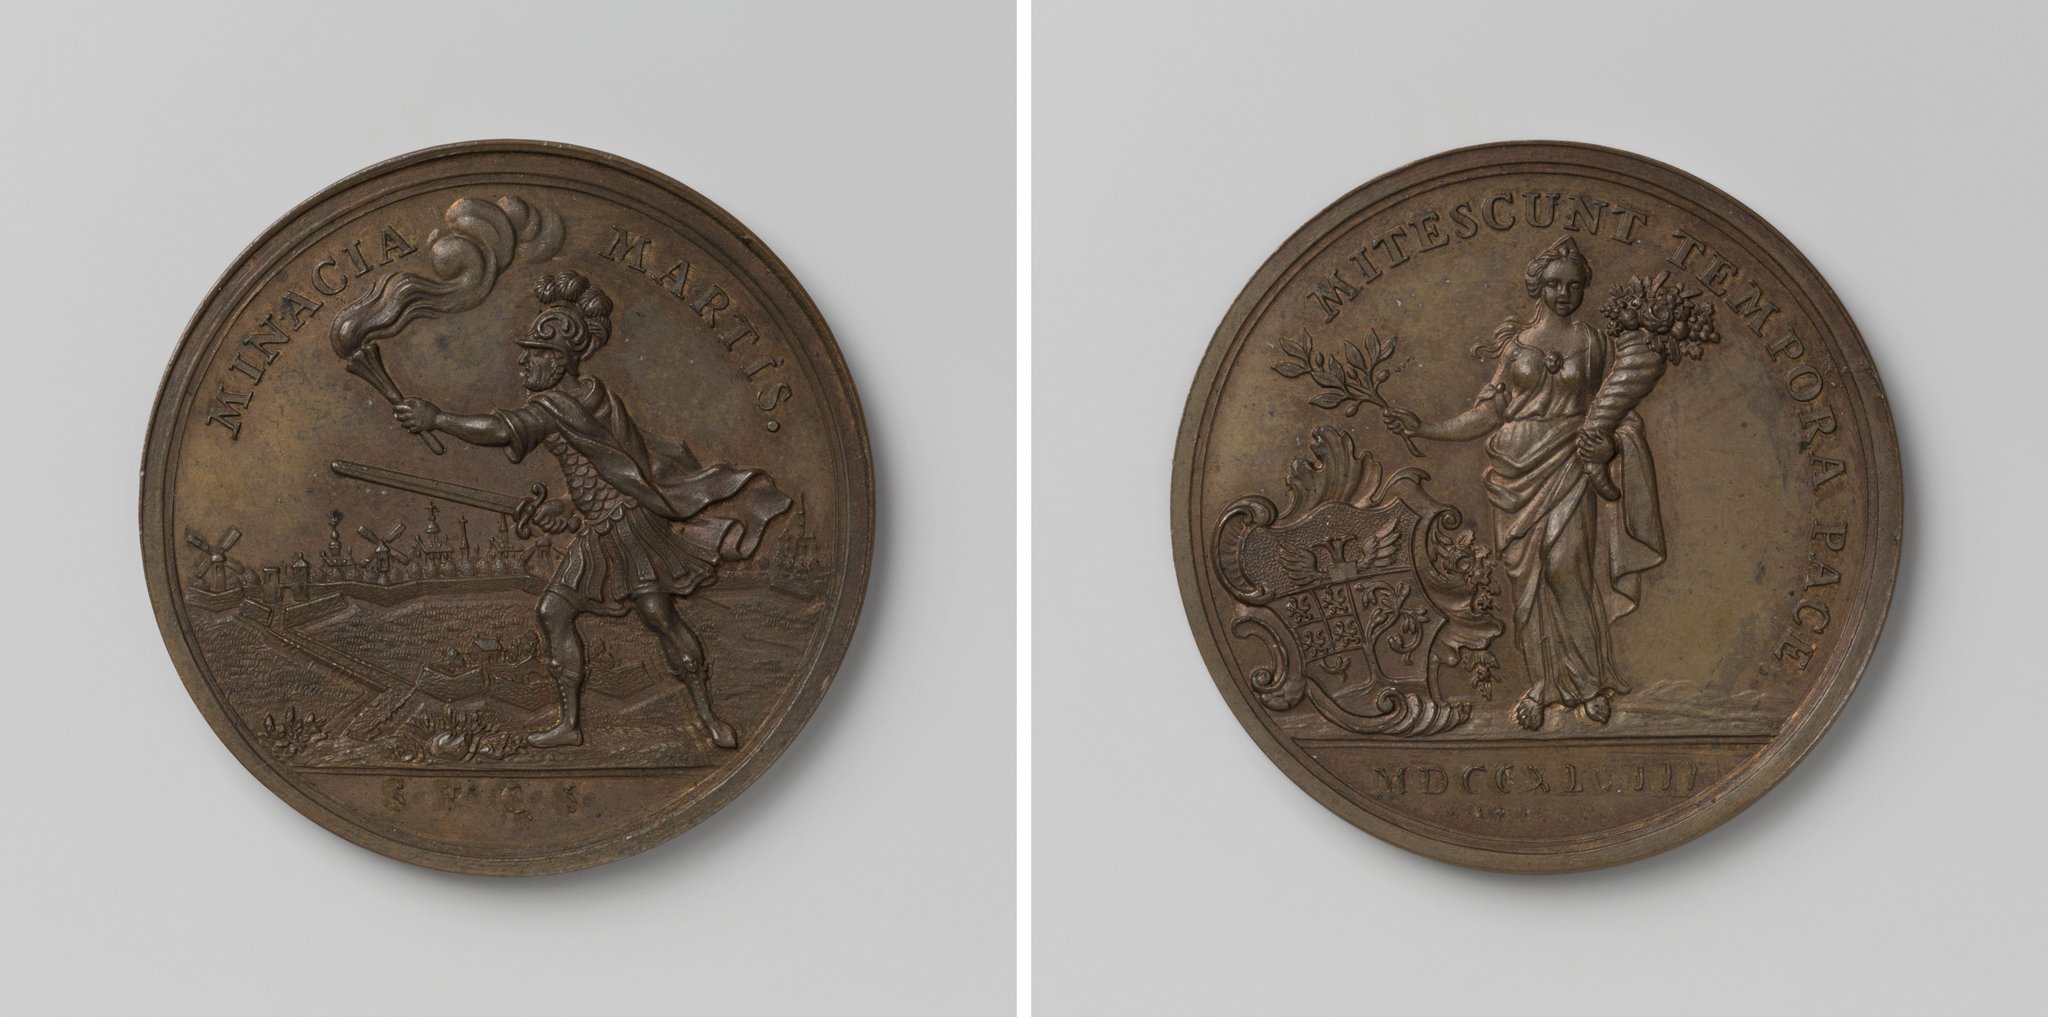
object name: council medal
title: 's-Hertogenbosch, vroedschapspenning op de vrede van Aken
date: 1748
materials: bronze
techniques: striking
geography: den bosch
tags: den bosch